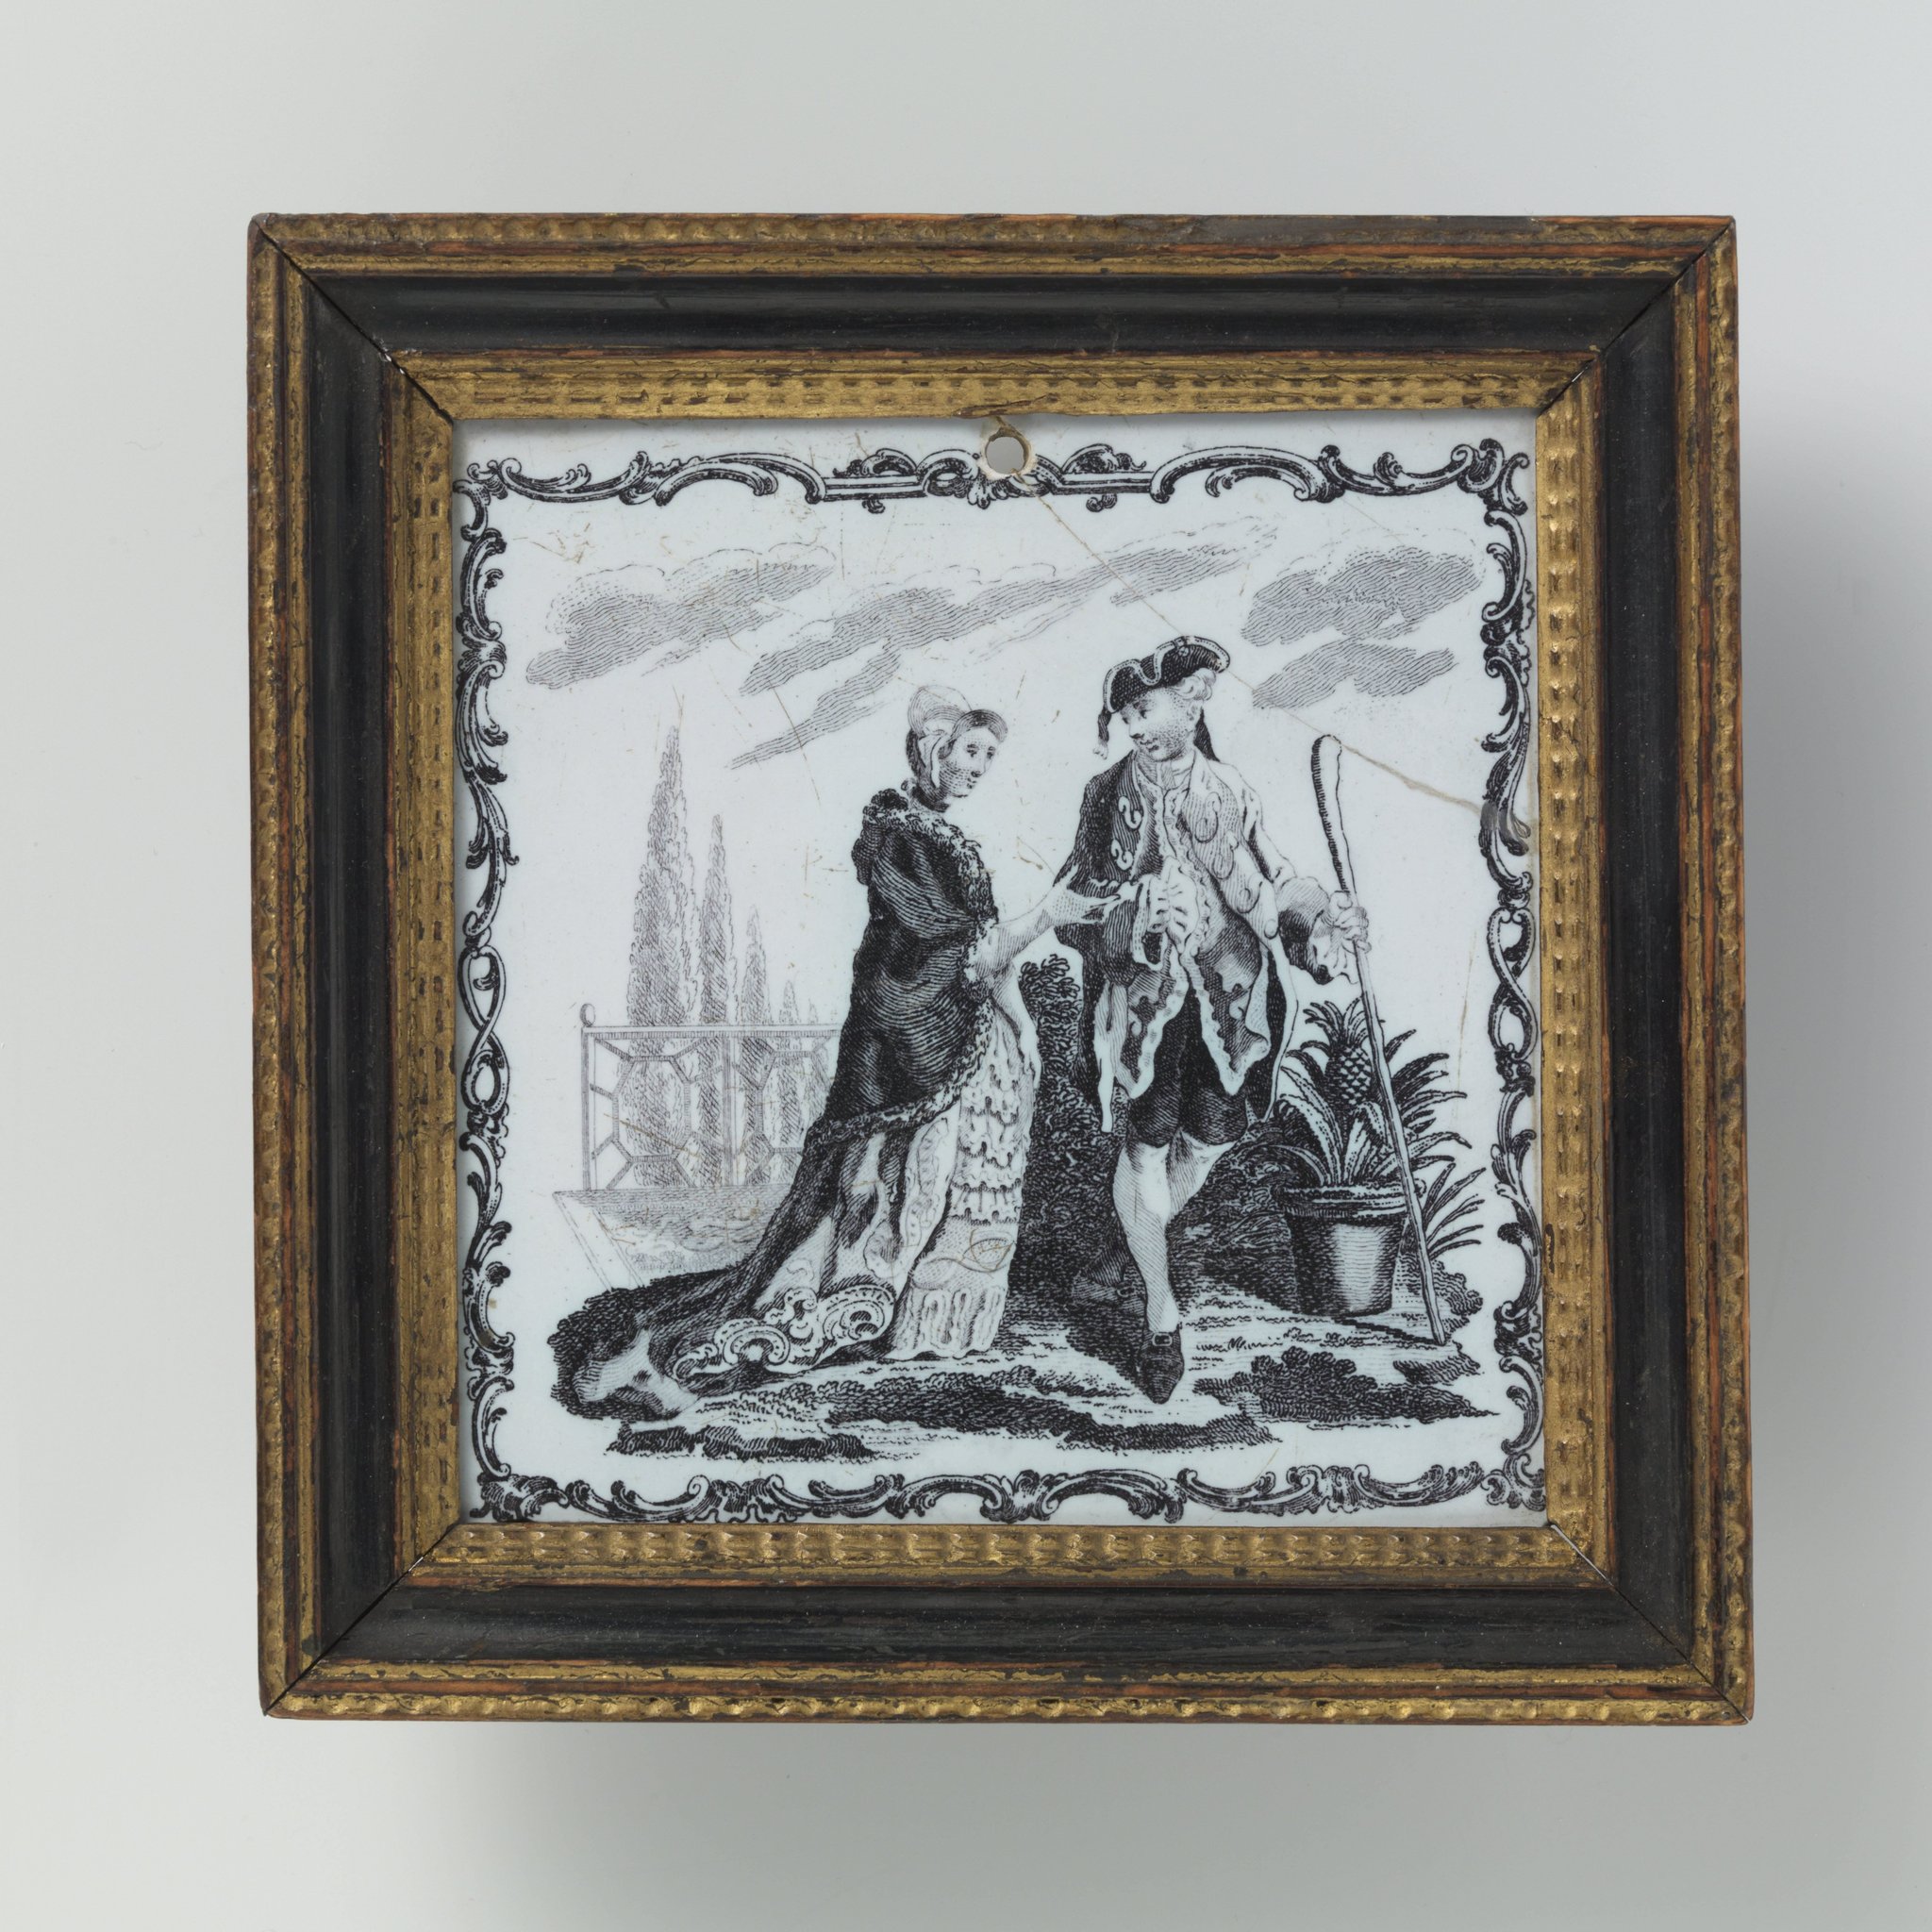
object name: tile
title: Tegel in lijst, met man en vrouw in 18e-eeuws kostuum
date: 1765-1775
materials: earthenware, glaze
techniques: maiolica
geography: liverpool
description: Tegel van tinglazuuraardewerk met een zwart transferdecor van een vrouw en een man in 18de-eeuws kostuum in een tuin, omlijst door rococo-ornament. De tegel is gevat in een lijst.